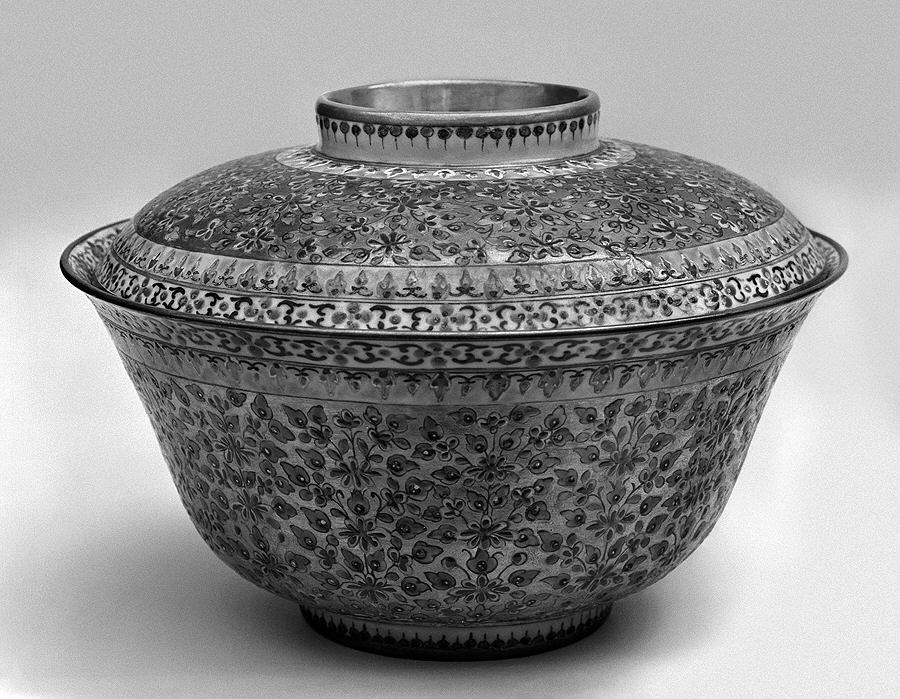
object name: bowl with cover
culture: chinese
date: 1736-1795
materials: porcelain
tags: flowers